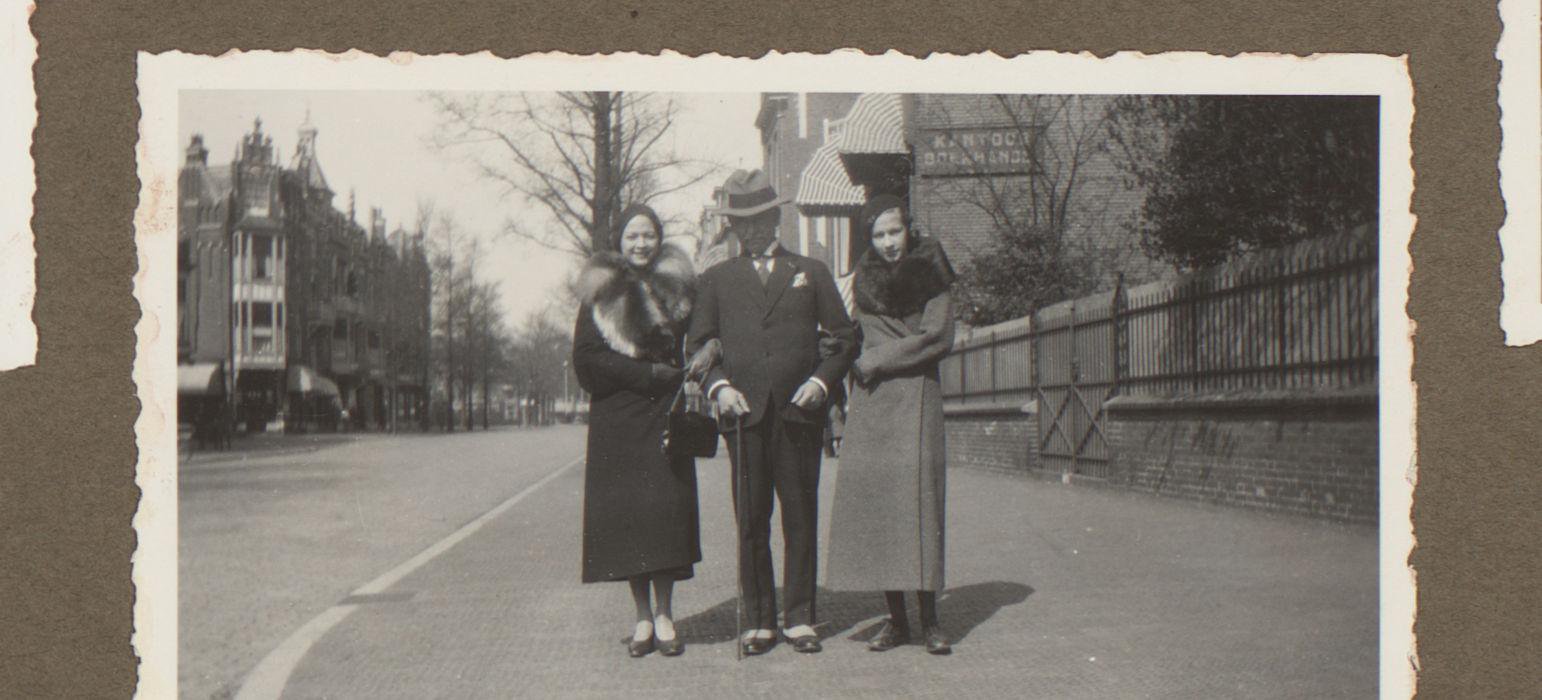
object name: album leaf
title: Gezelschap op straat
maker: Anonymous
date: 1933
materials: paper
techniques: gelatin silver print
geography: the hague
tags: street, anonymous historical persons portrayed in a group, in a group-portrait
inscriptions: inscription: ‘Oom Labree + Emy’